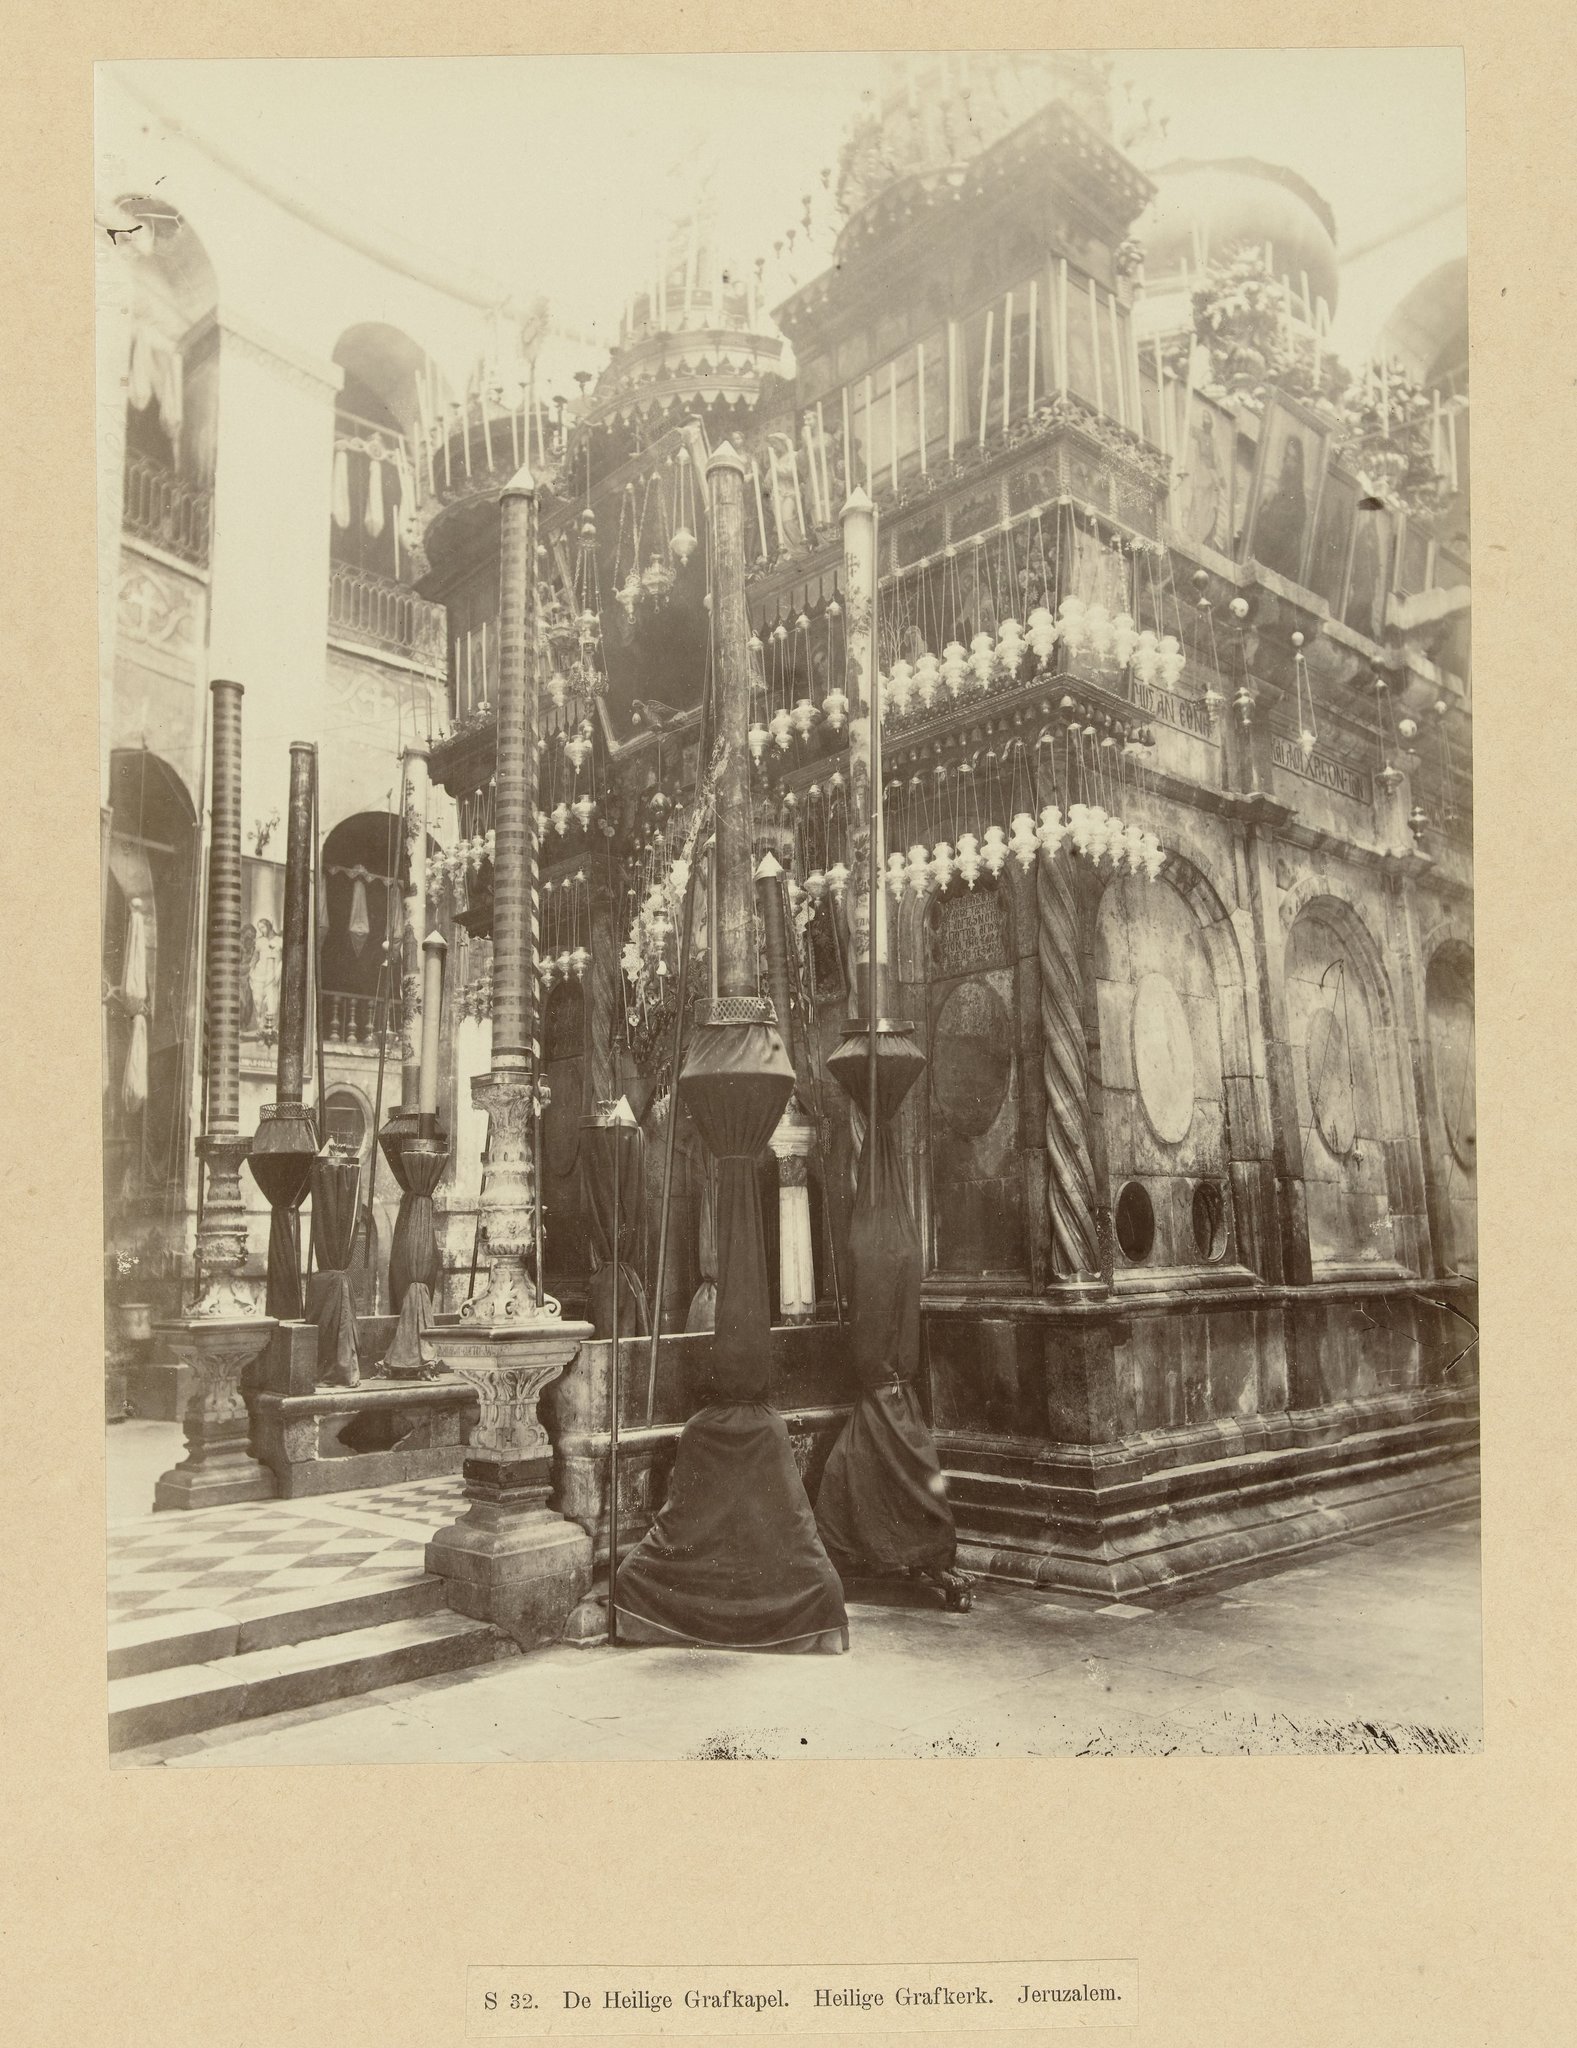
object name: photograph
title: Heilig Graf in de Heilig Grafkerk, Jeruzalem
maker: Anonymous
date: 1890-1895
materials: cardboard, paper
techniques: albumen print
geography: jerusalem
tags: grave, tomb, interior of church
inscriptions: title: ‘S 32. De Heilige Grafkapel. Heilige Grafkerk. Jeruzalem.’, stamp: ‘Gemeentelijke bibliotheek/ Rotterdam’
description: Onderdeel van een groep door fotograaf Richard Polak op reis verzamelde foto’s. Deze foto is samen met andere op zijn reizen verzamelde foto's tentoongesteld bij de Rotterdamsche Kunstkring (1895), Arti en Amicitiae te Amsterdam (1897-1898?) en Societeit 't Collegie te Kampen (datum vooralsnog onbekend).